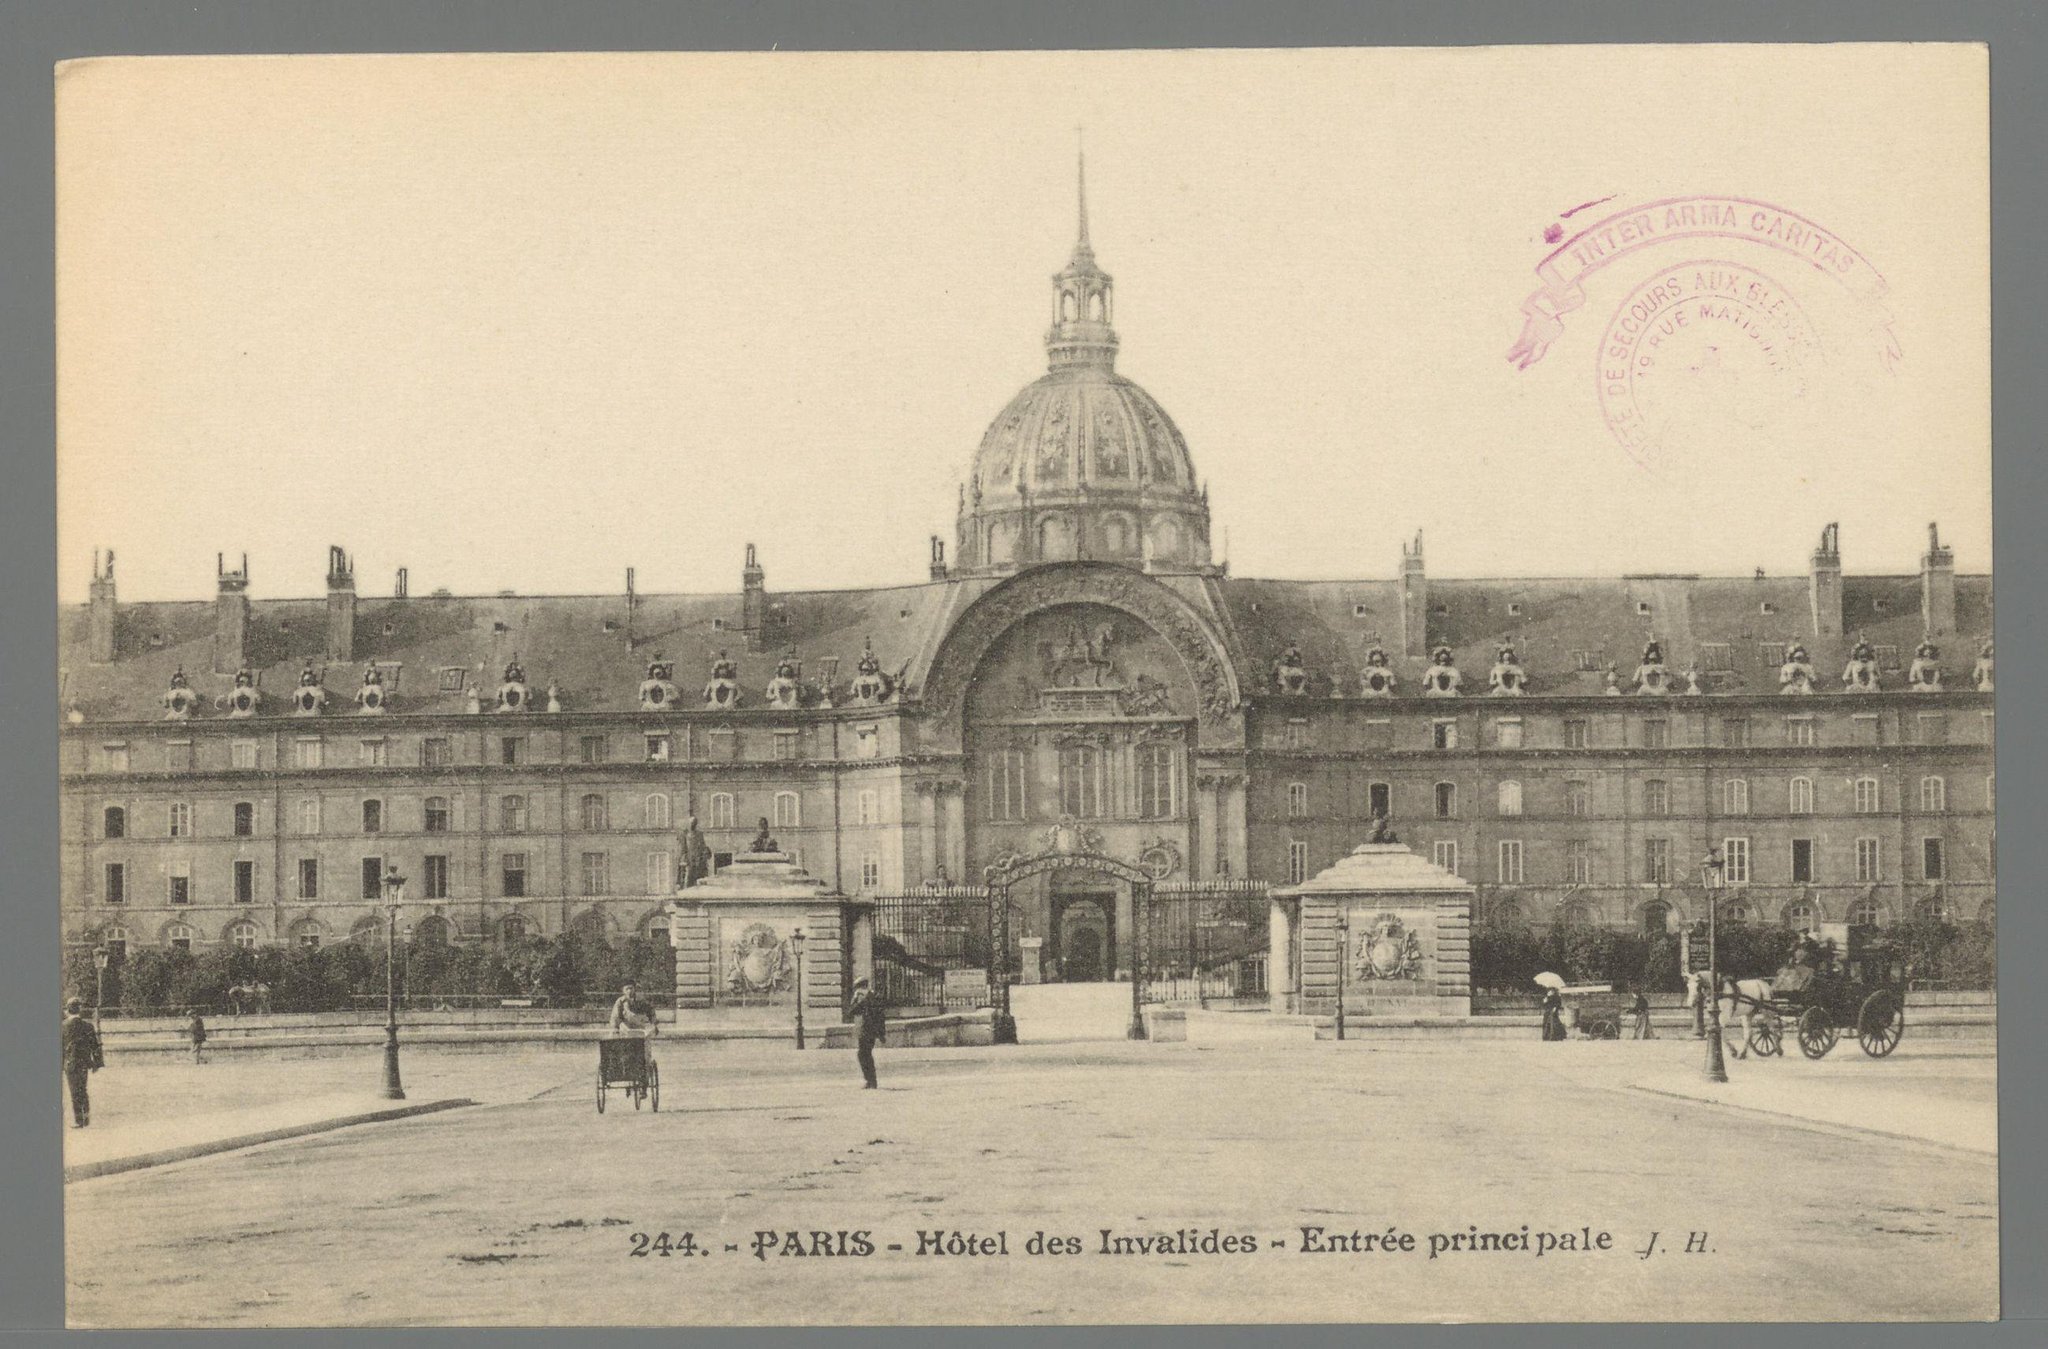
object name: photomechanical print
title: Paris. Hôtel des Invalides. Entrée principale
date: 1903-1920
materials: cardboard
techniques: photograph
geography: paris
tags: exterior ~ representation of a building, square, place, circus, etc. (+ city(-scape) with figures, staffage)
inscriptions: stamp: ‘Inter Arma Caritas. Société de Secours aux Blessés Militaires. 19 Rue Matignon. Paris’